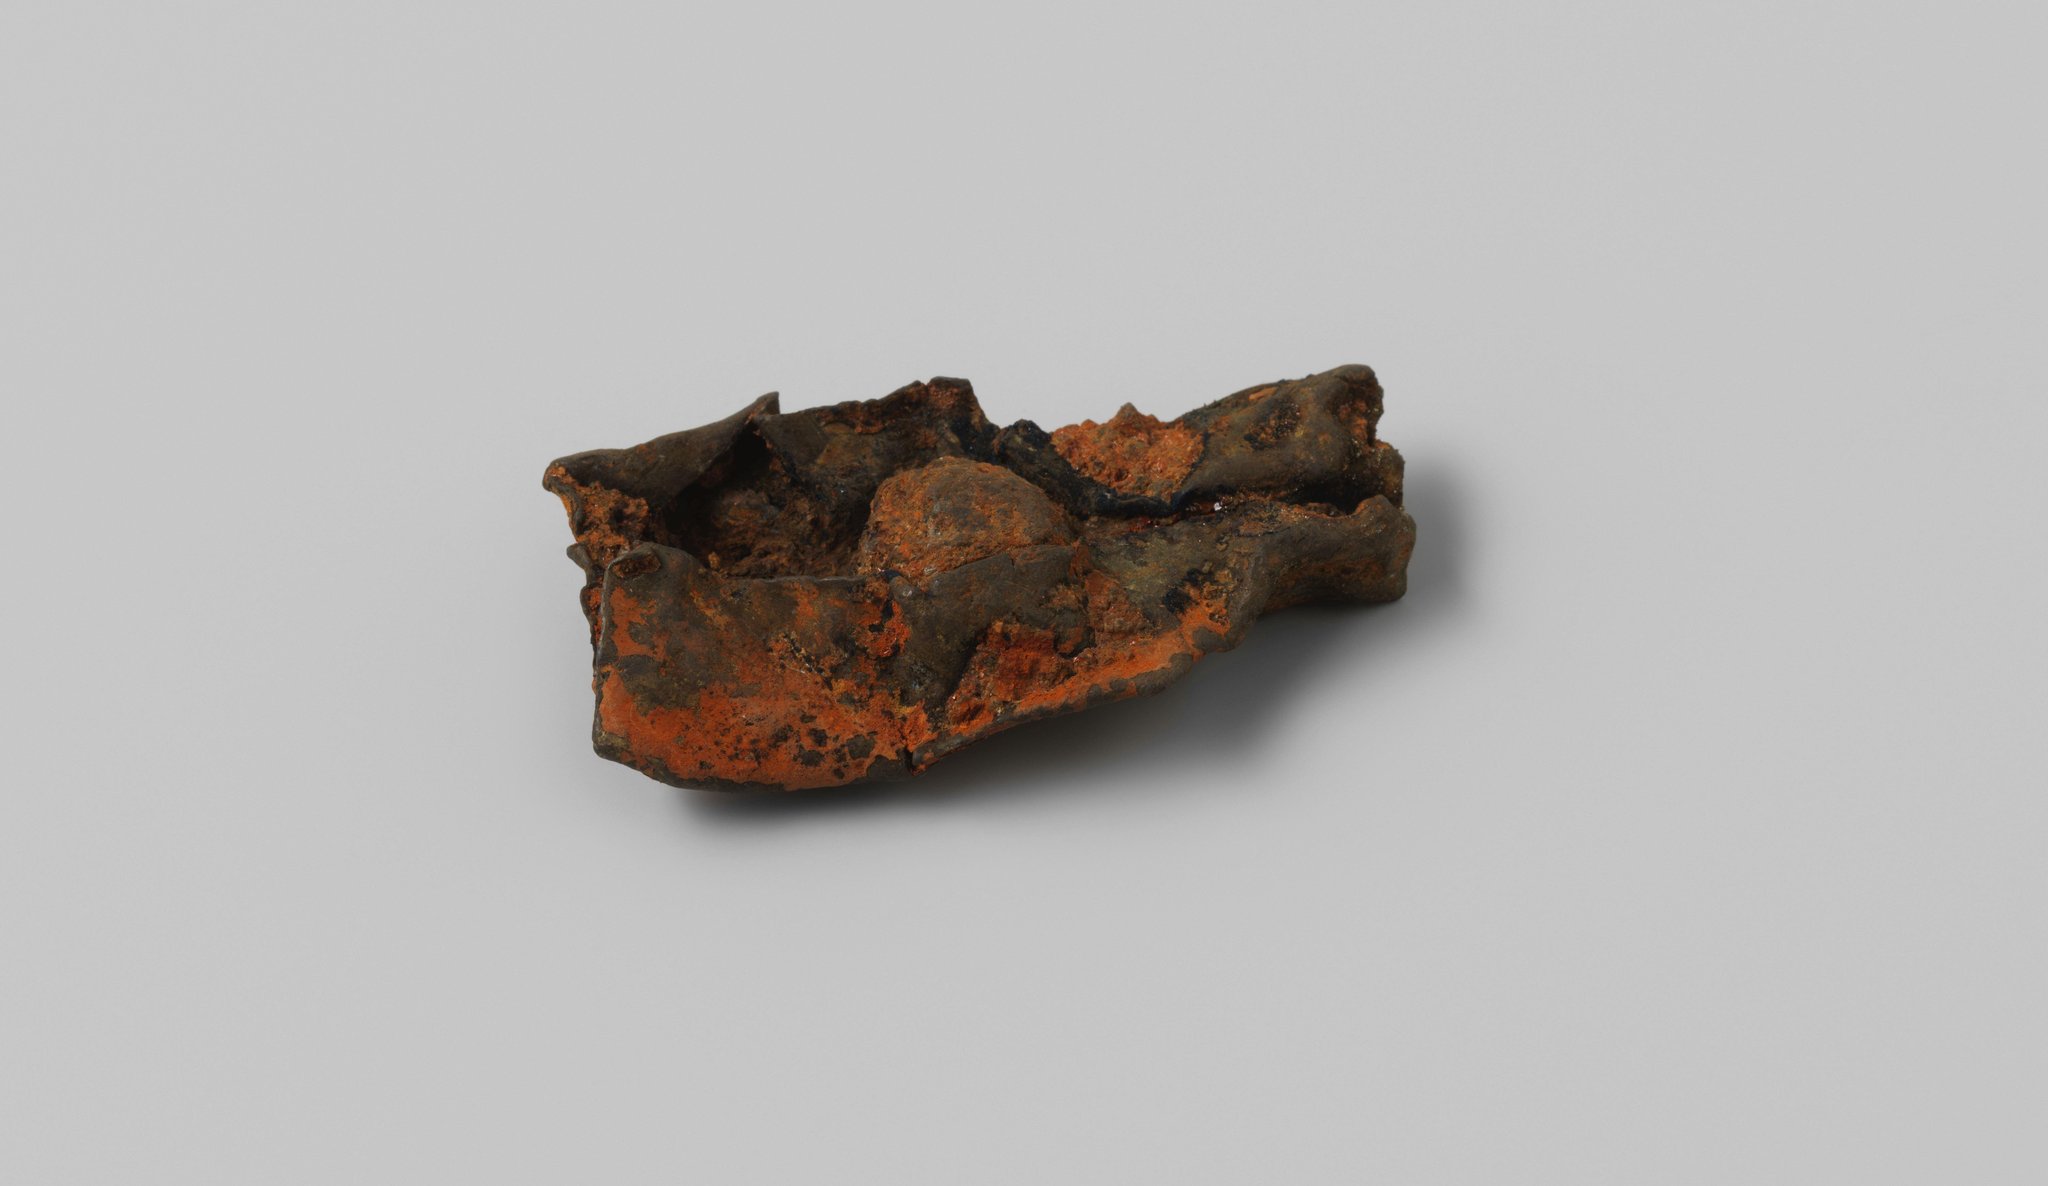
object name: cartridge shell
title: Patroonhuls met kogel uit het wrak van de Oost-Indiëvaarder Hollandia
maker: Anonymous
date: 1700-1743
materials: stone, copper, lead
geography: netherlands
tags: verenigde oostindische compagnie, hollandia (schip), annet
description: Cartridge case, tube; fragm, squashed, bent, id. NG 1979-205H549 with lead shot.